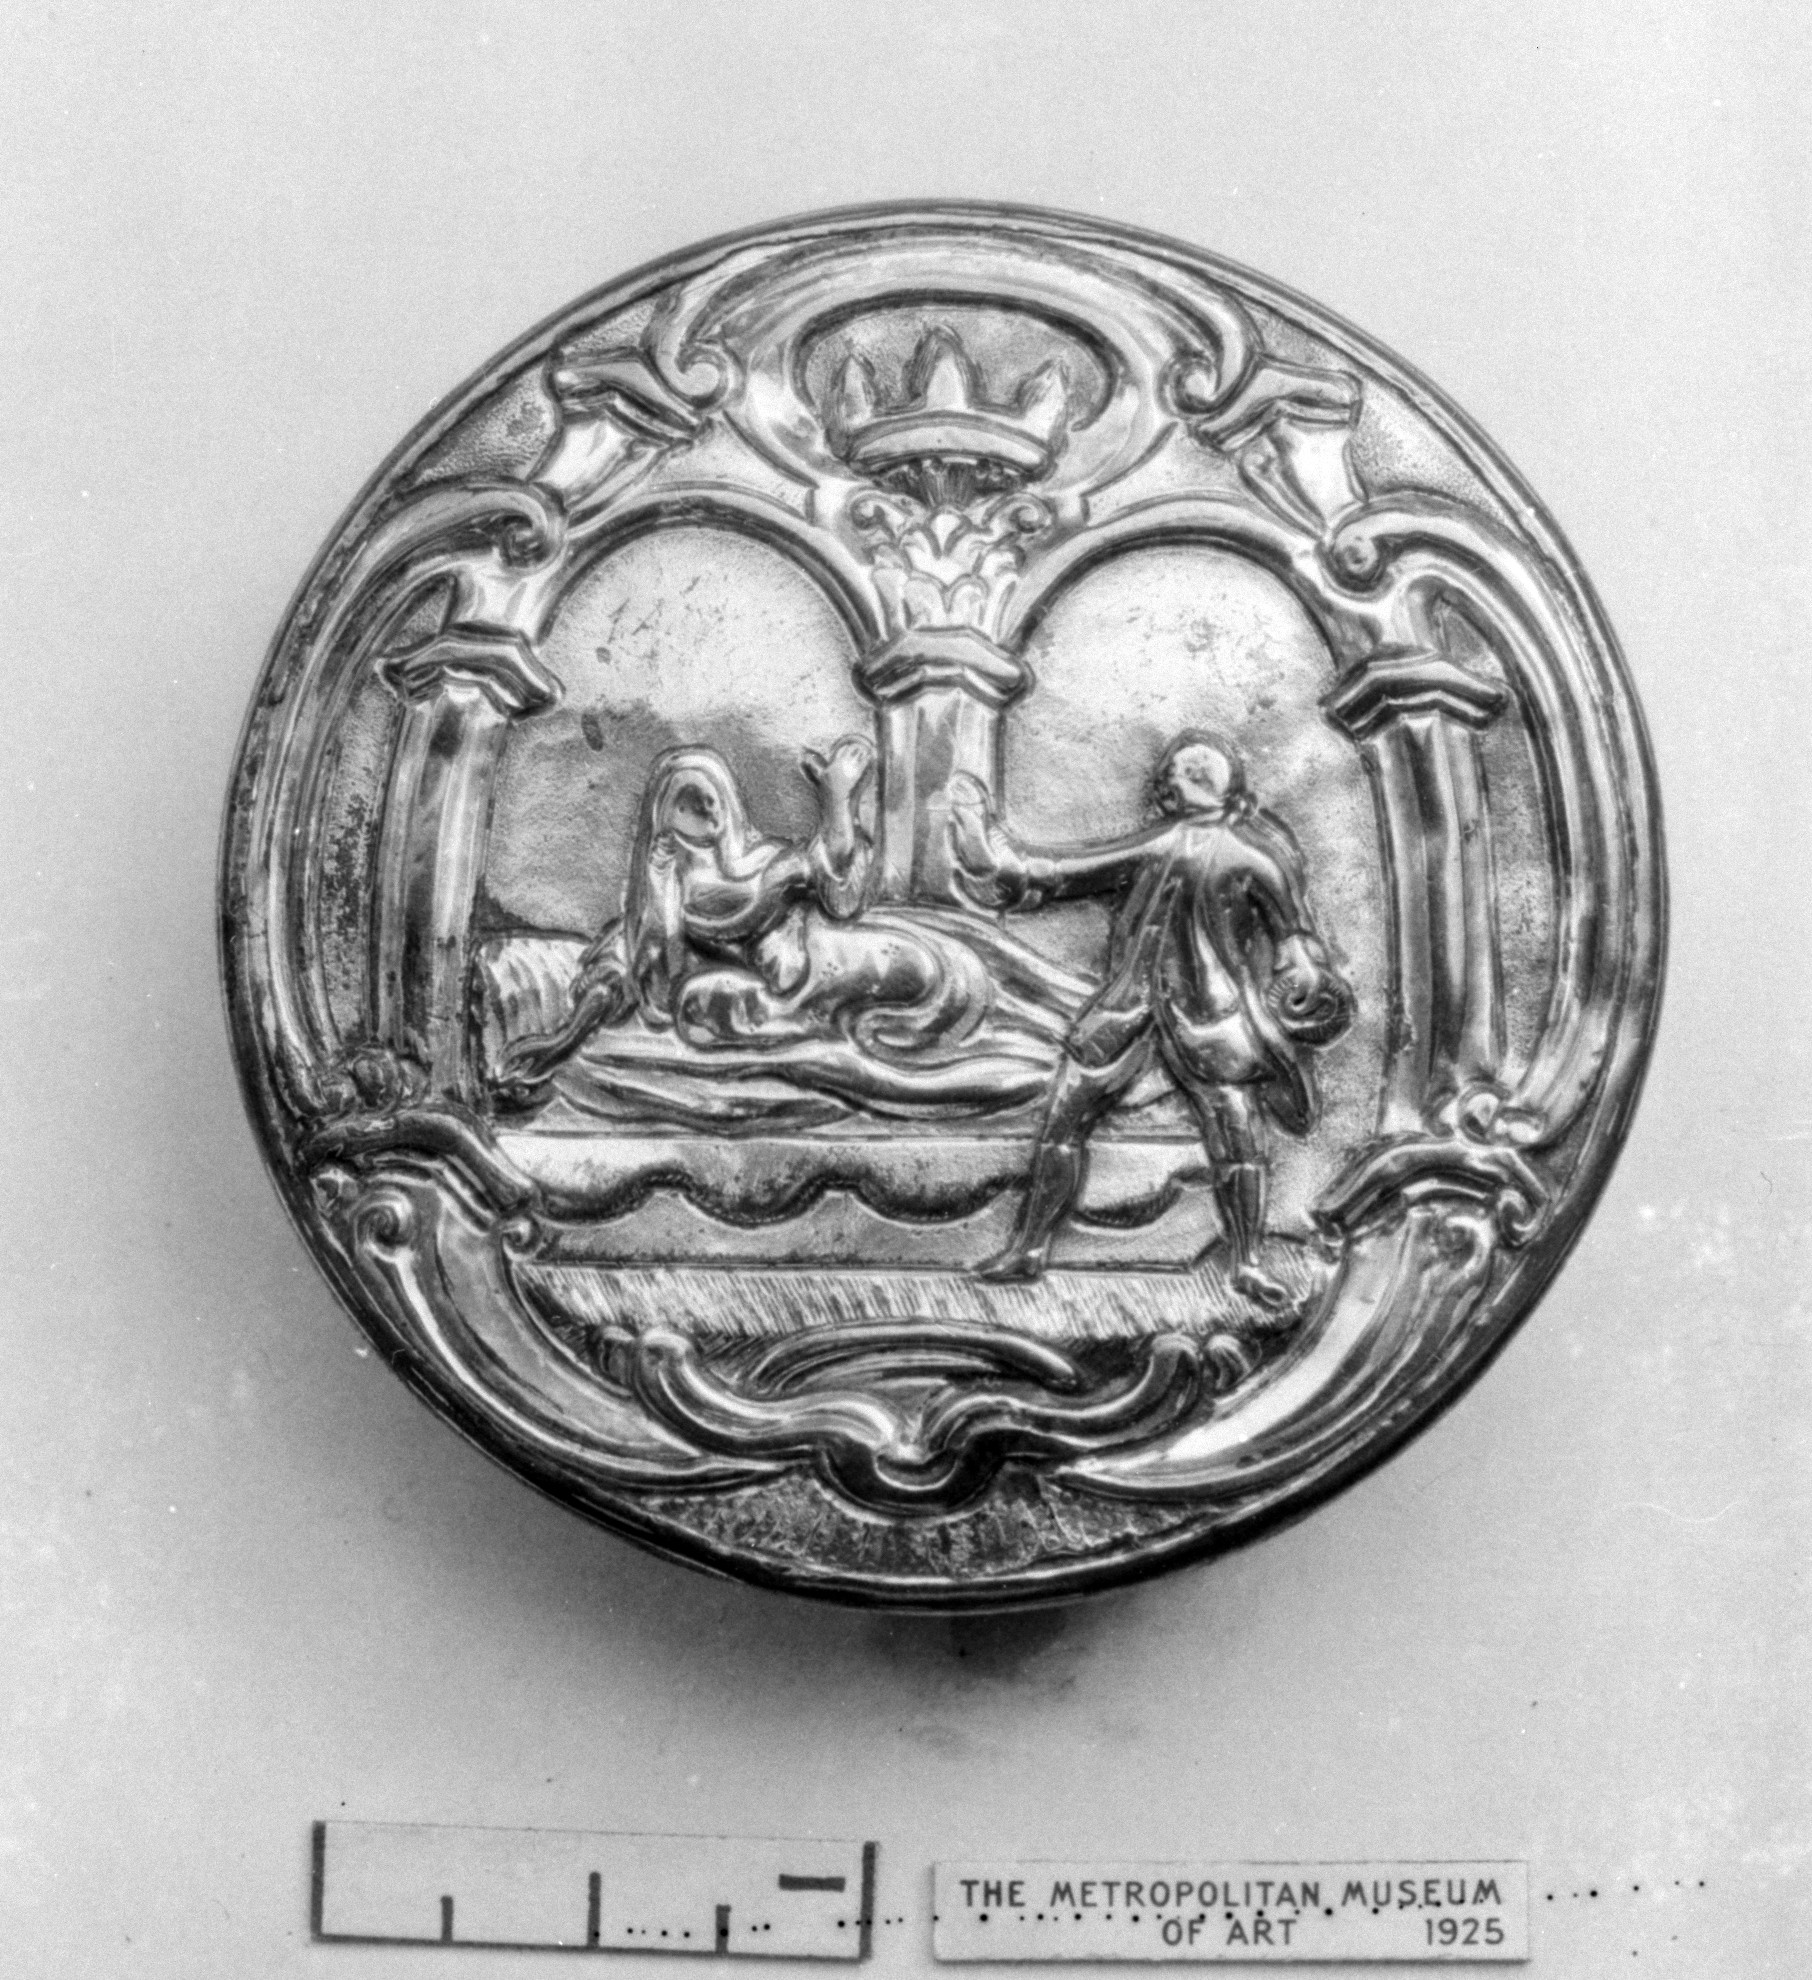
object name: snuffbox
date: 1750-1760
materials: metal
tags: men,women